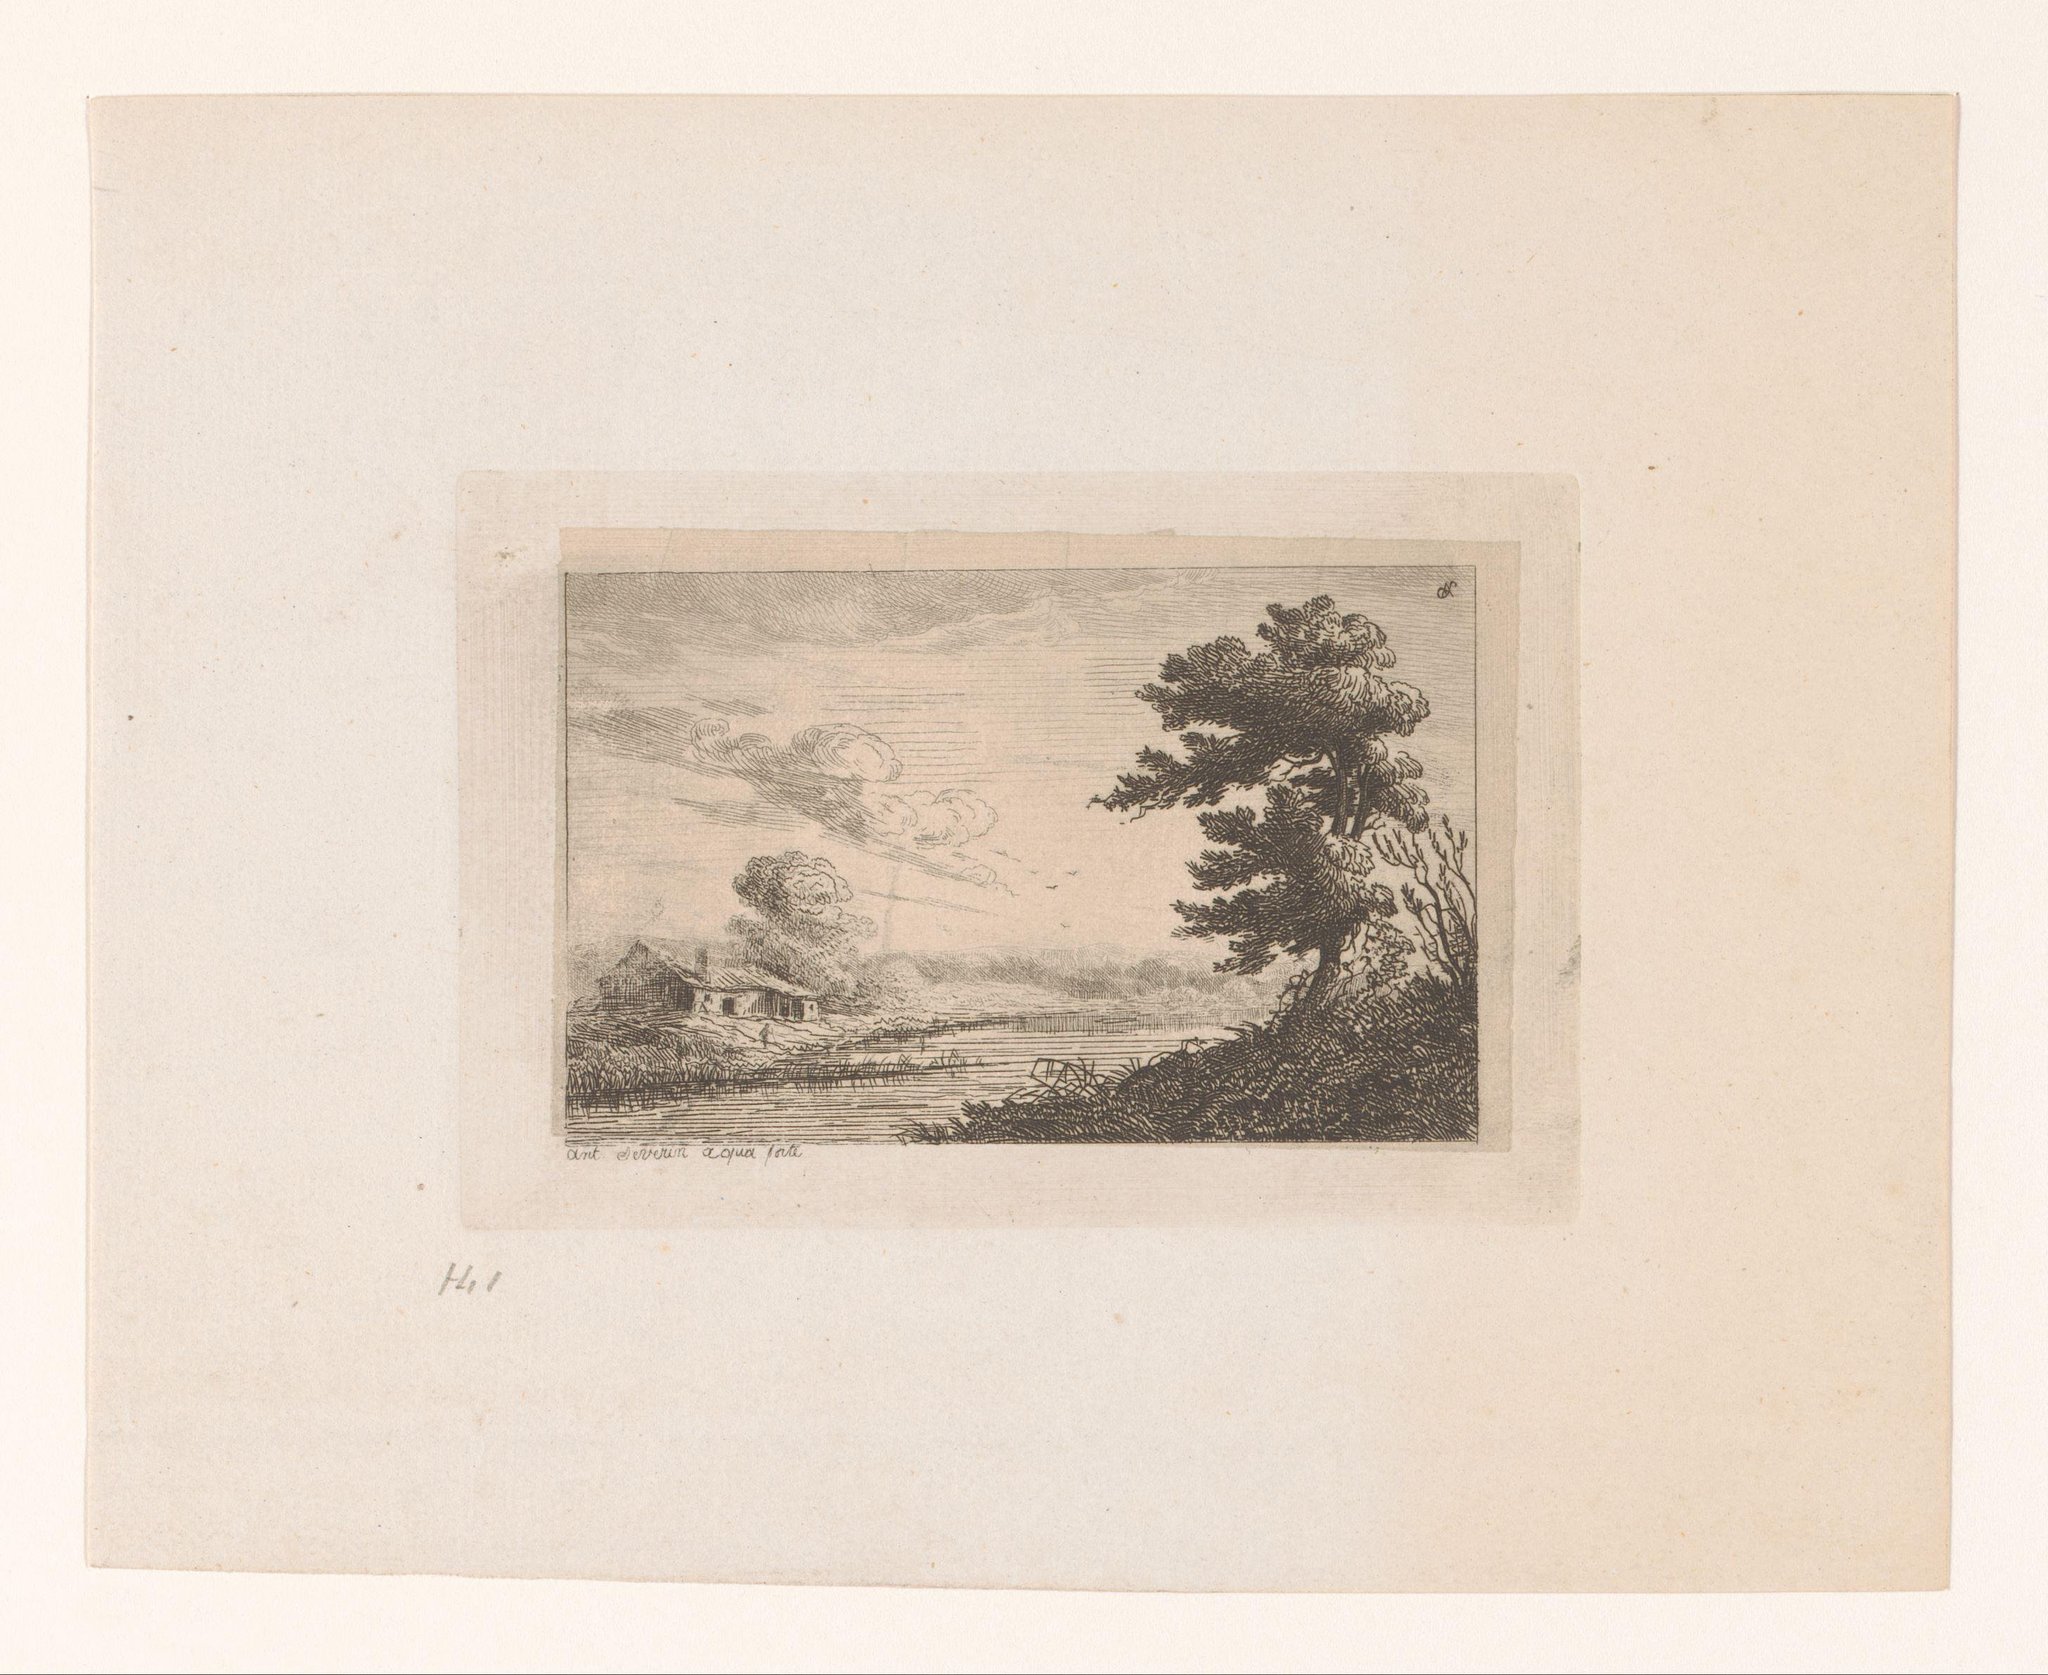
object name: print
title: Gravures à l'eau-forte par A. Severin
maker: antoine severin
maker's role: print maker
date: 1851-1852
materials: paper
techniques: drypoint, etching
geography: brussels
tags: river, hut, cabin, lodge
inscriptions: collector's mark: Lugt 2228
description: Prent maakt deel uit van een serie van negen prenten.